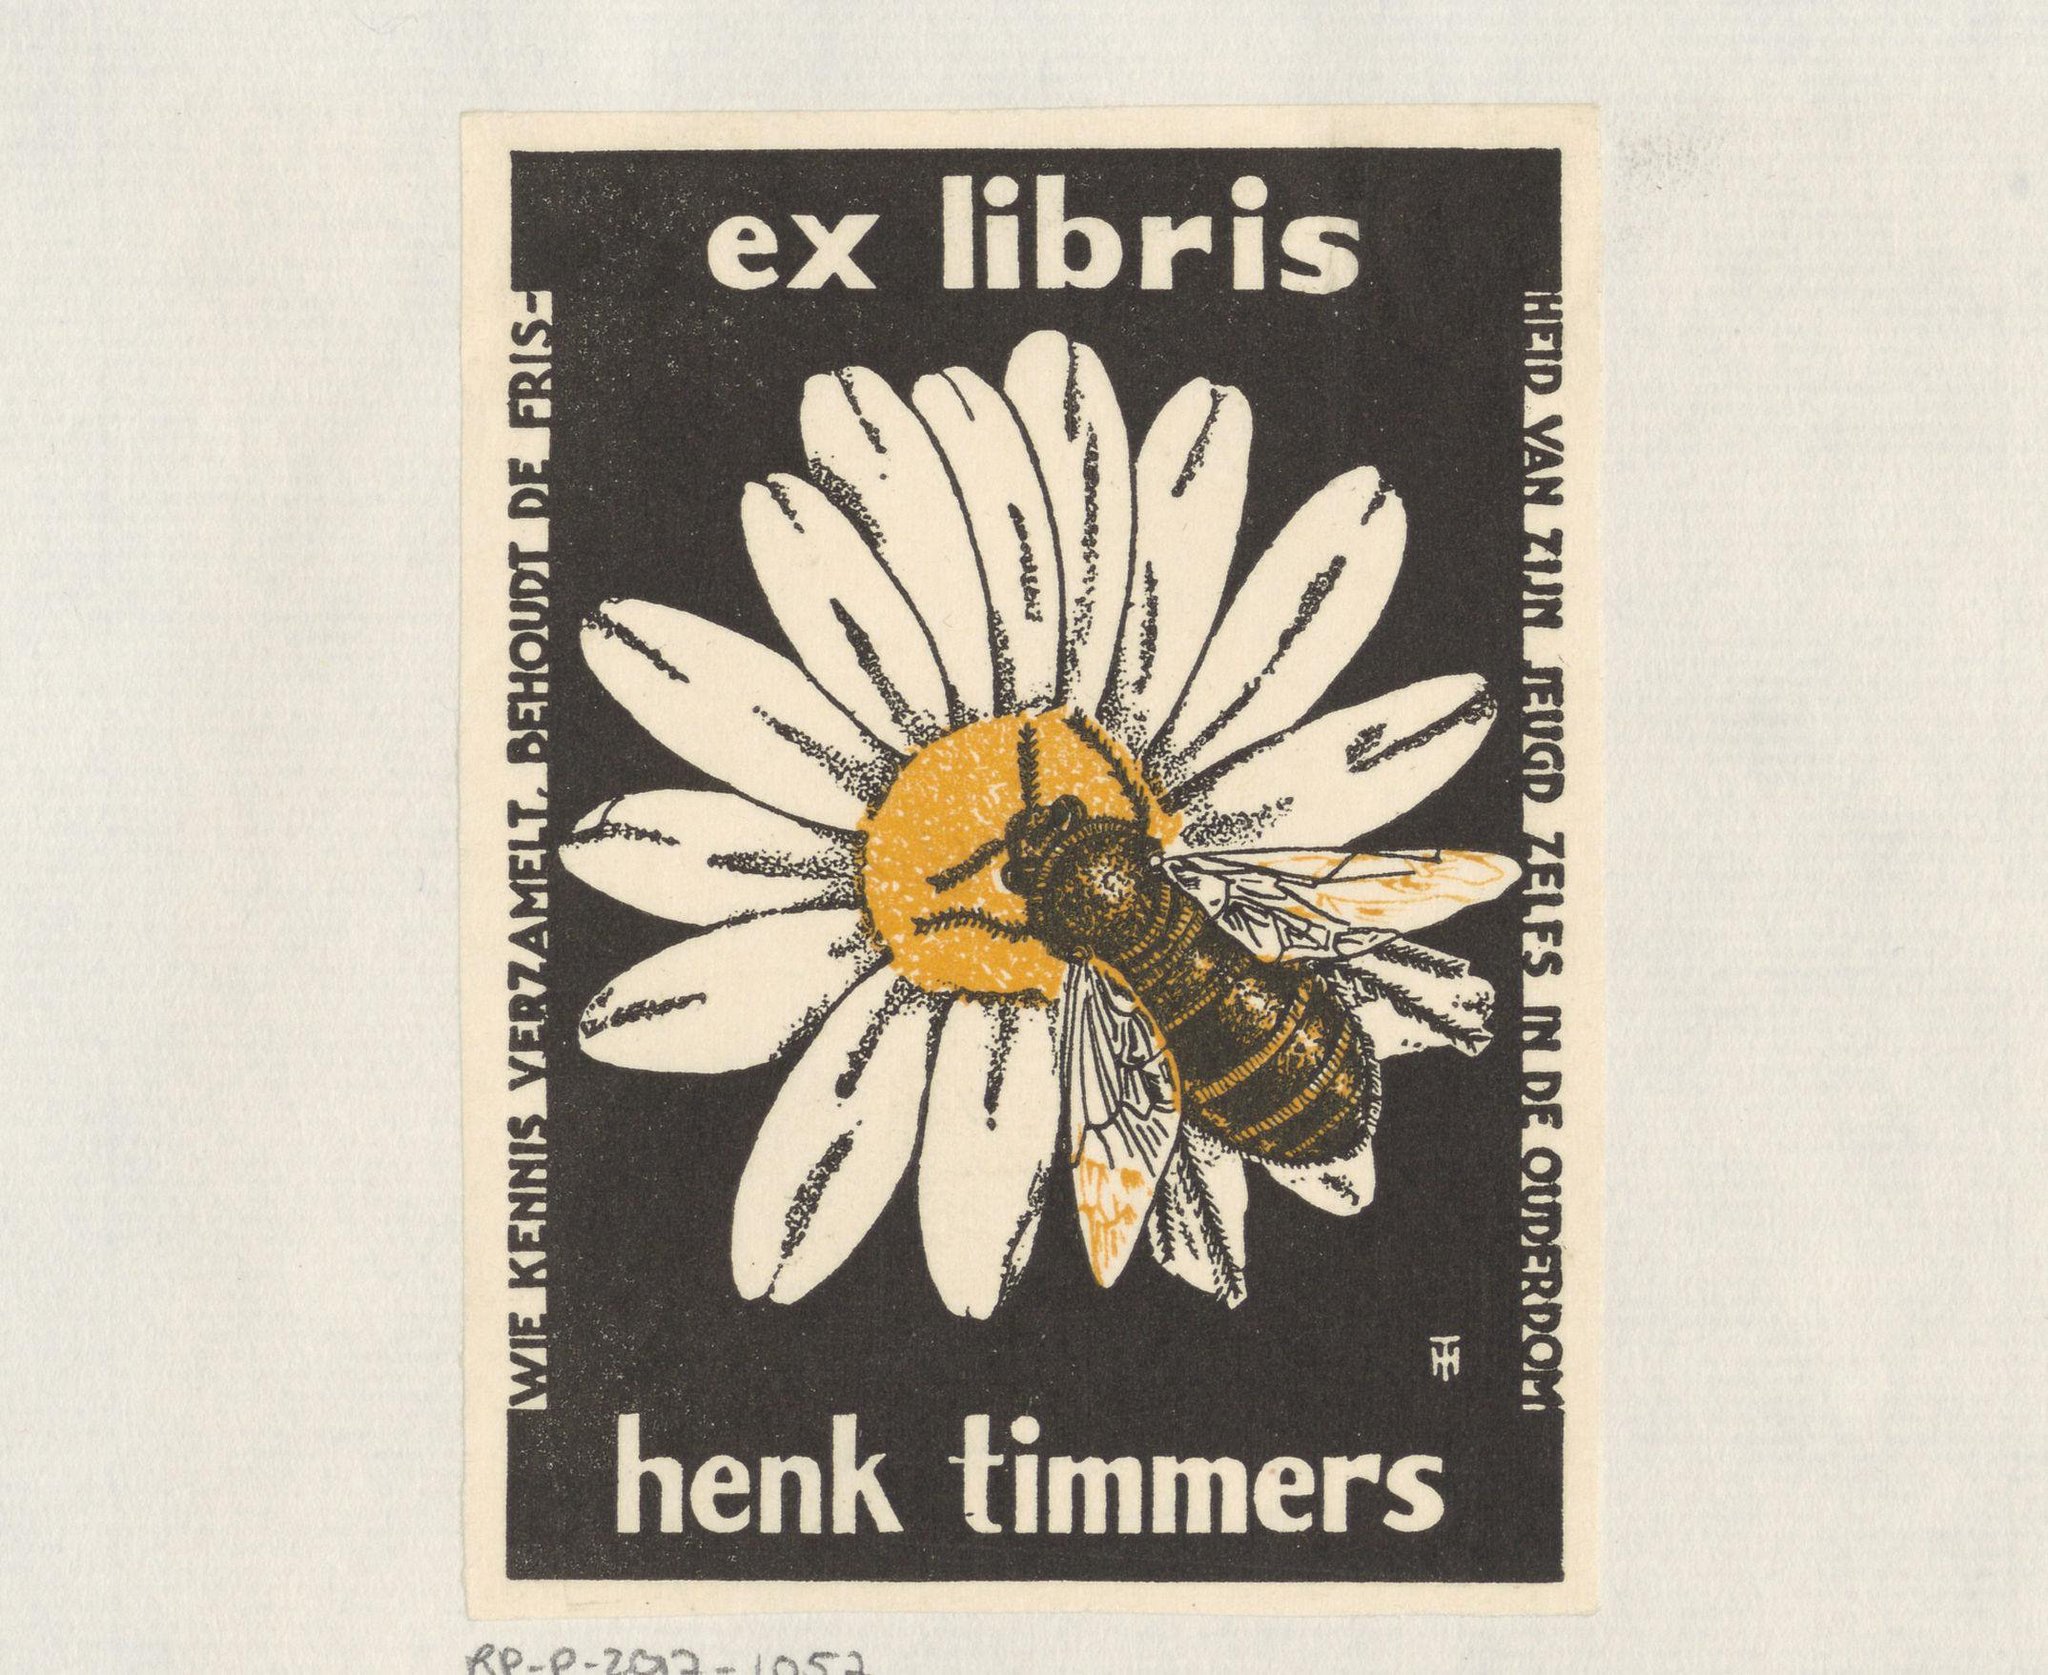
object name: bookplate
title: Ex libris van Henk Timmers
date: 1944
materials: paper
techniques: printing block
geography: netherlands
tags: painter, henk timmers, flowers: daisy, insects: bee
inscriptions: inscription: ‘Cl. H. Timmers '44 / Holland’